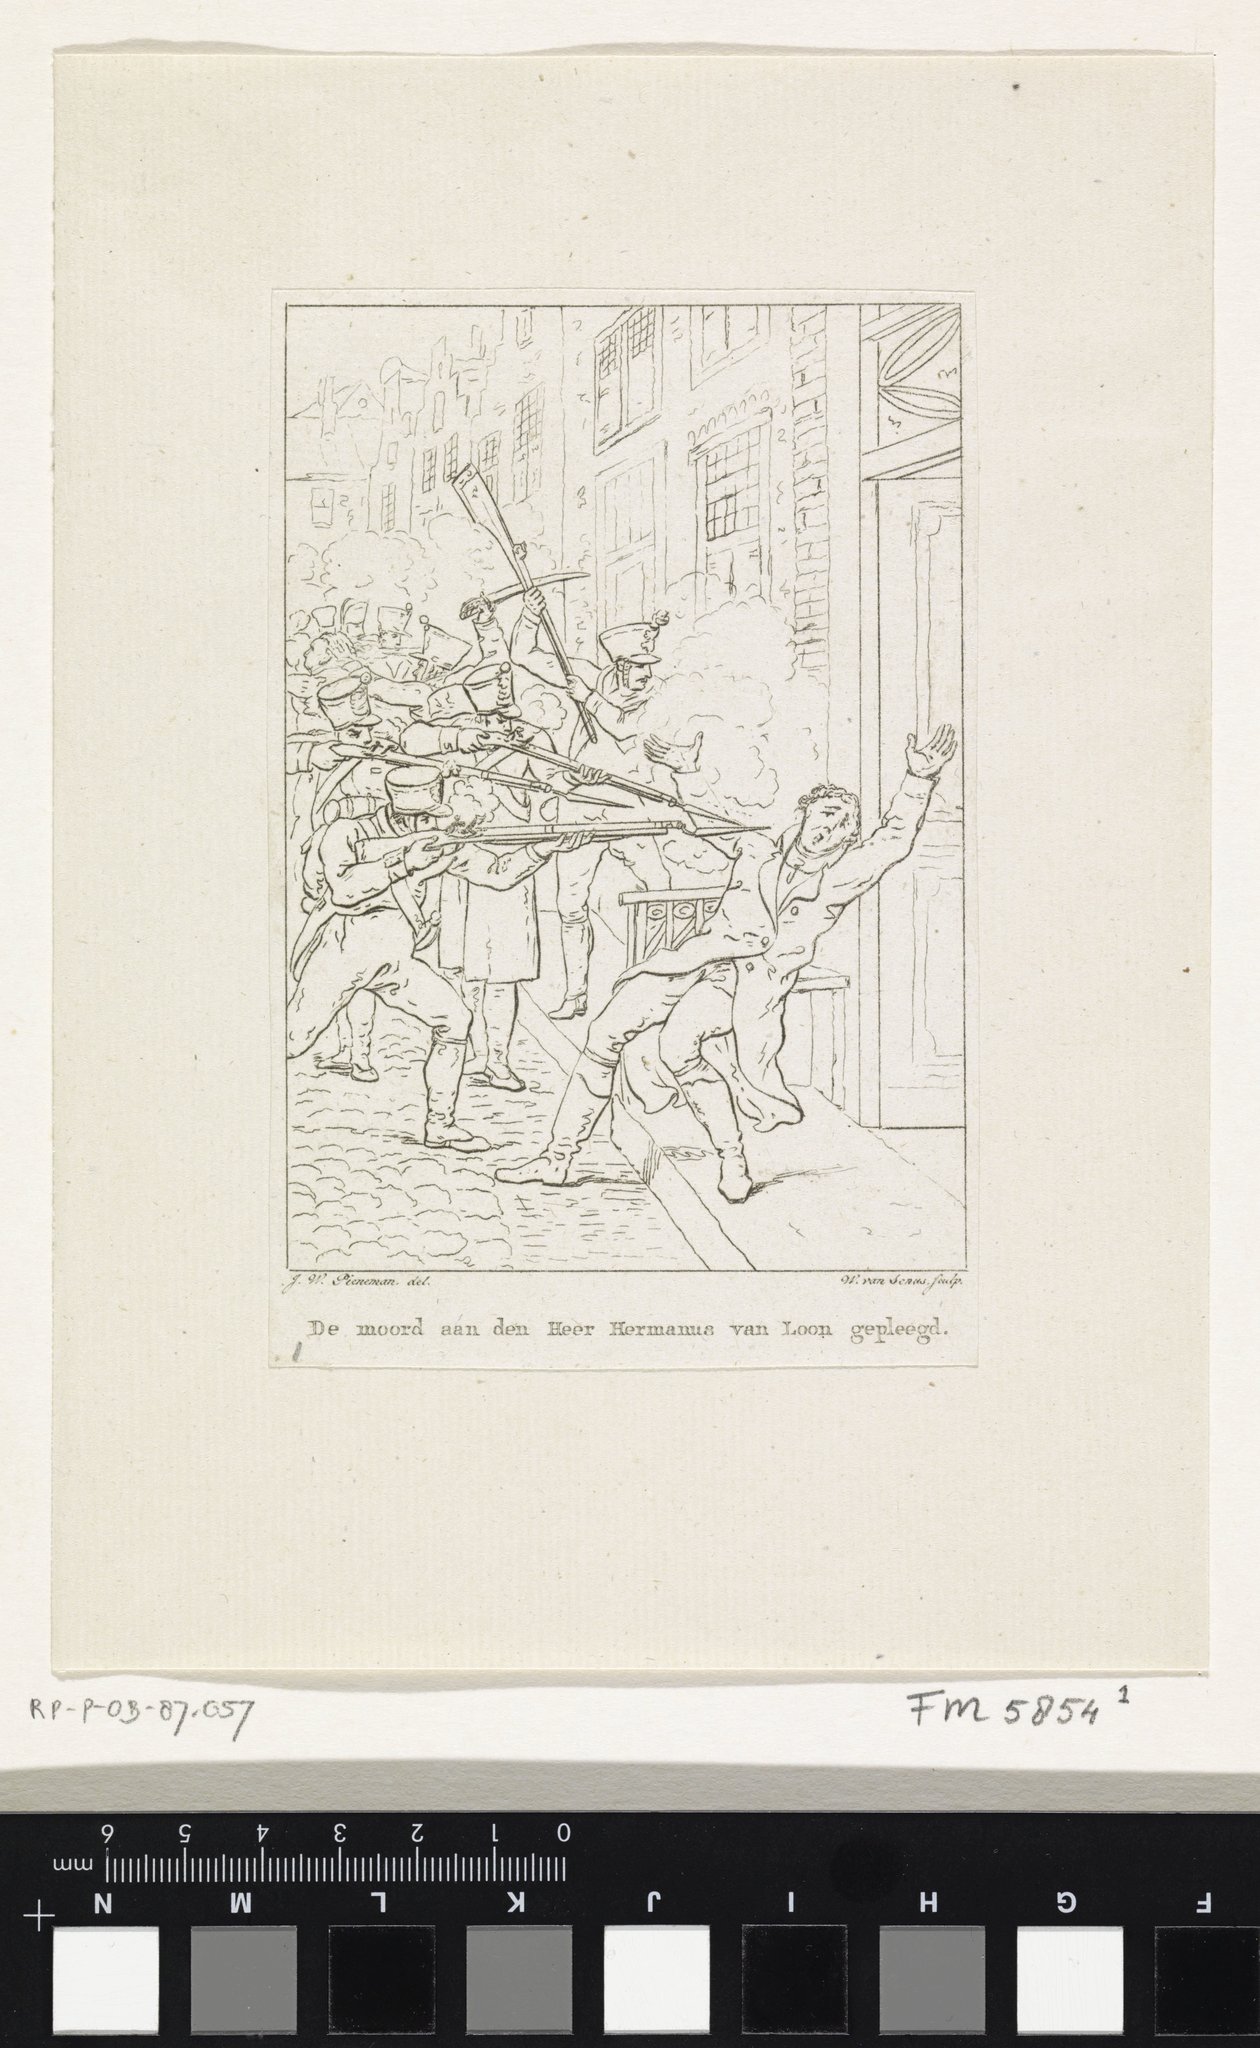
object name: print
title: Moord te Woerden op H. van Loon, 1813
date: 1813-1814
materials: paper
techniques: etching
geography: netherlands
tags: war and crime, murder, plundering ~ soldiers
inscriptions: collector's mark: Lugt 2228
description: Hermanus van Loon voor zijn huis doodgeschoten door Franse militairen. Onderdeel van een groep illustraties in omtrek van de gruwelijkheden begaan door de Franse troepen tijdens de overrompeling en plundering van Woerden op 24 en 25 november 1813.